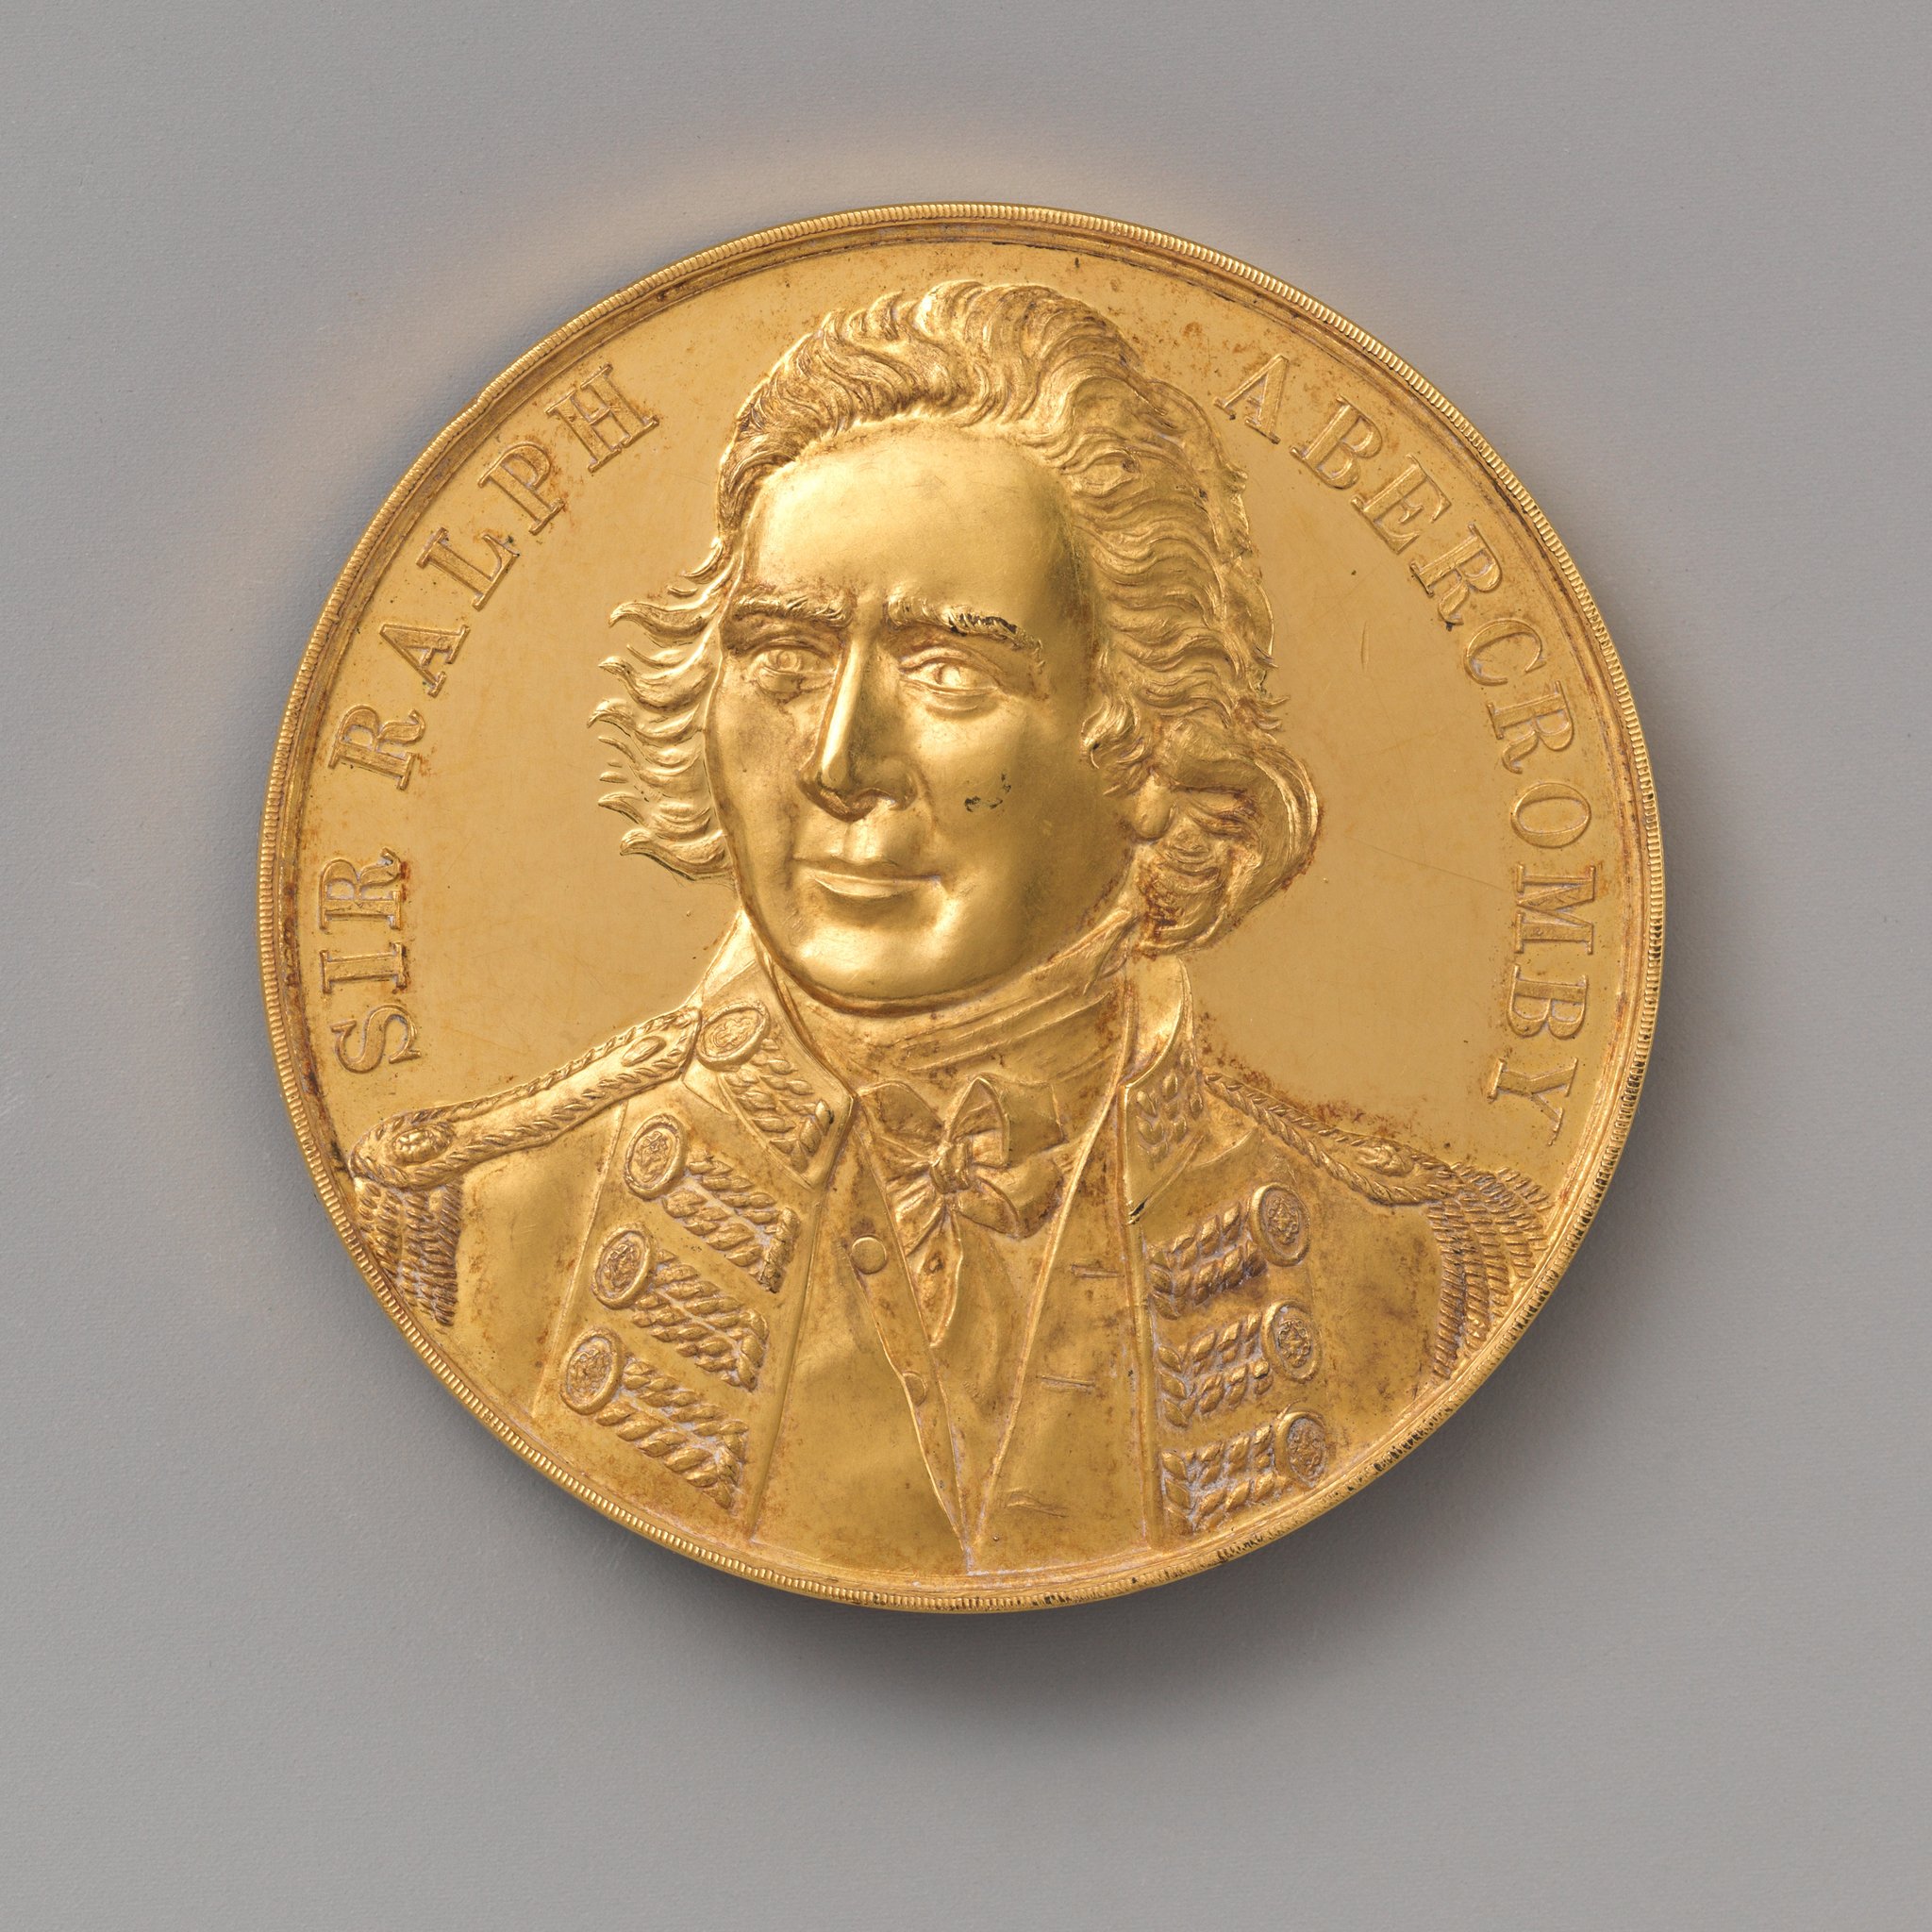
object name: medal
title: Centenary of the Conquest of Trinidad by the British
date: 1801-1900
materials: gold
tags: men,portraits,ships